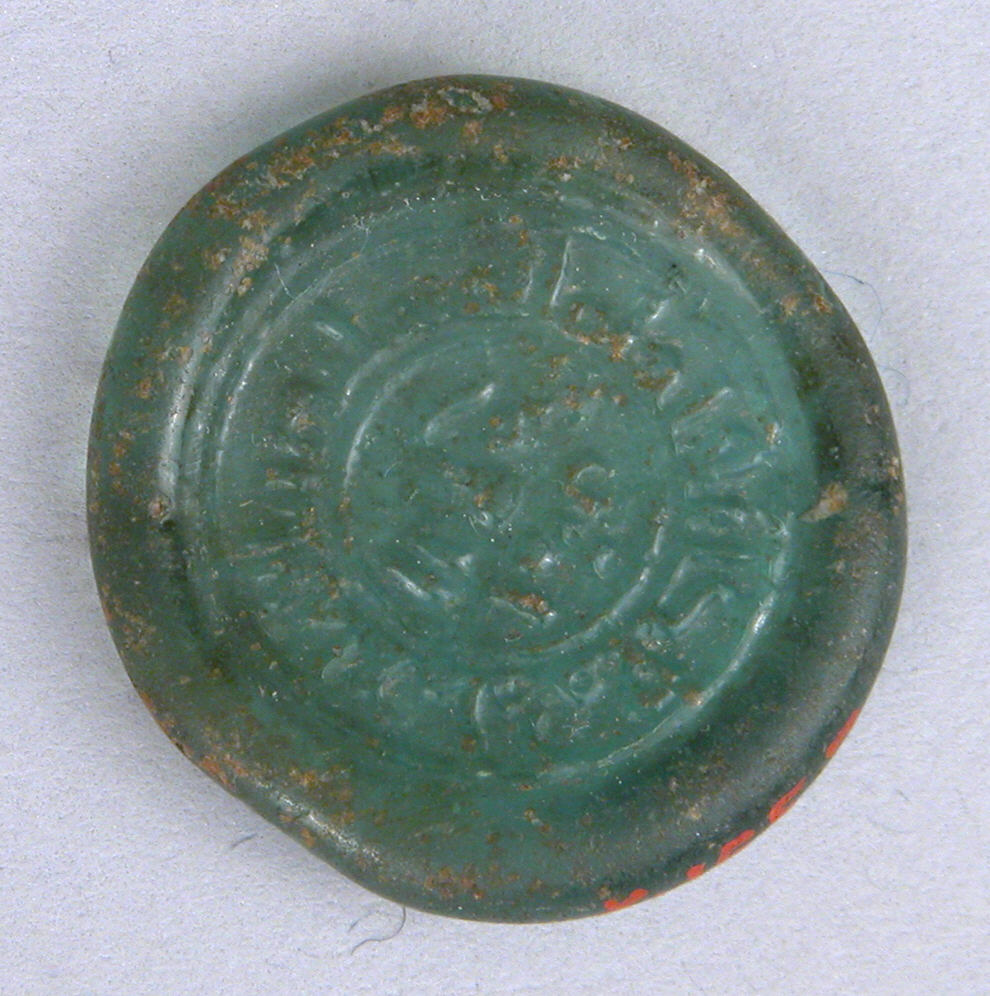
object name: coin weight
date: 1001-1100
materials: glass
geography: egypt